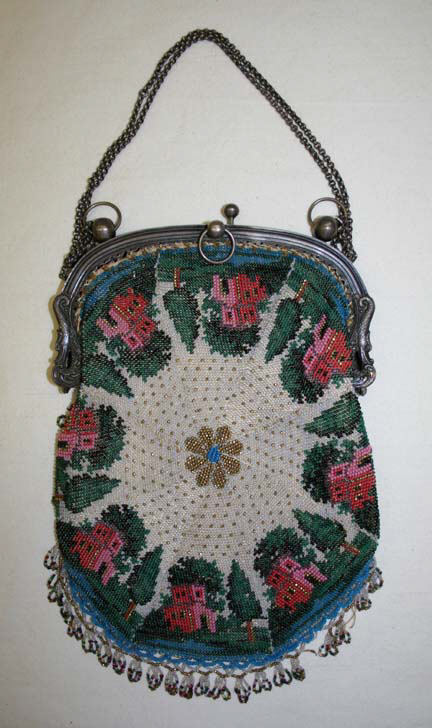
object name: bag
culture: french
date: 1820-1830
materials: silver